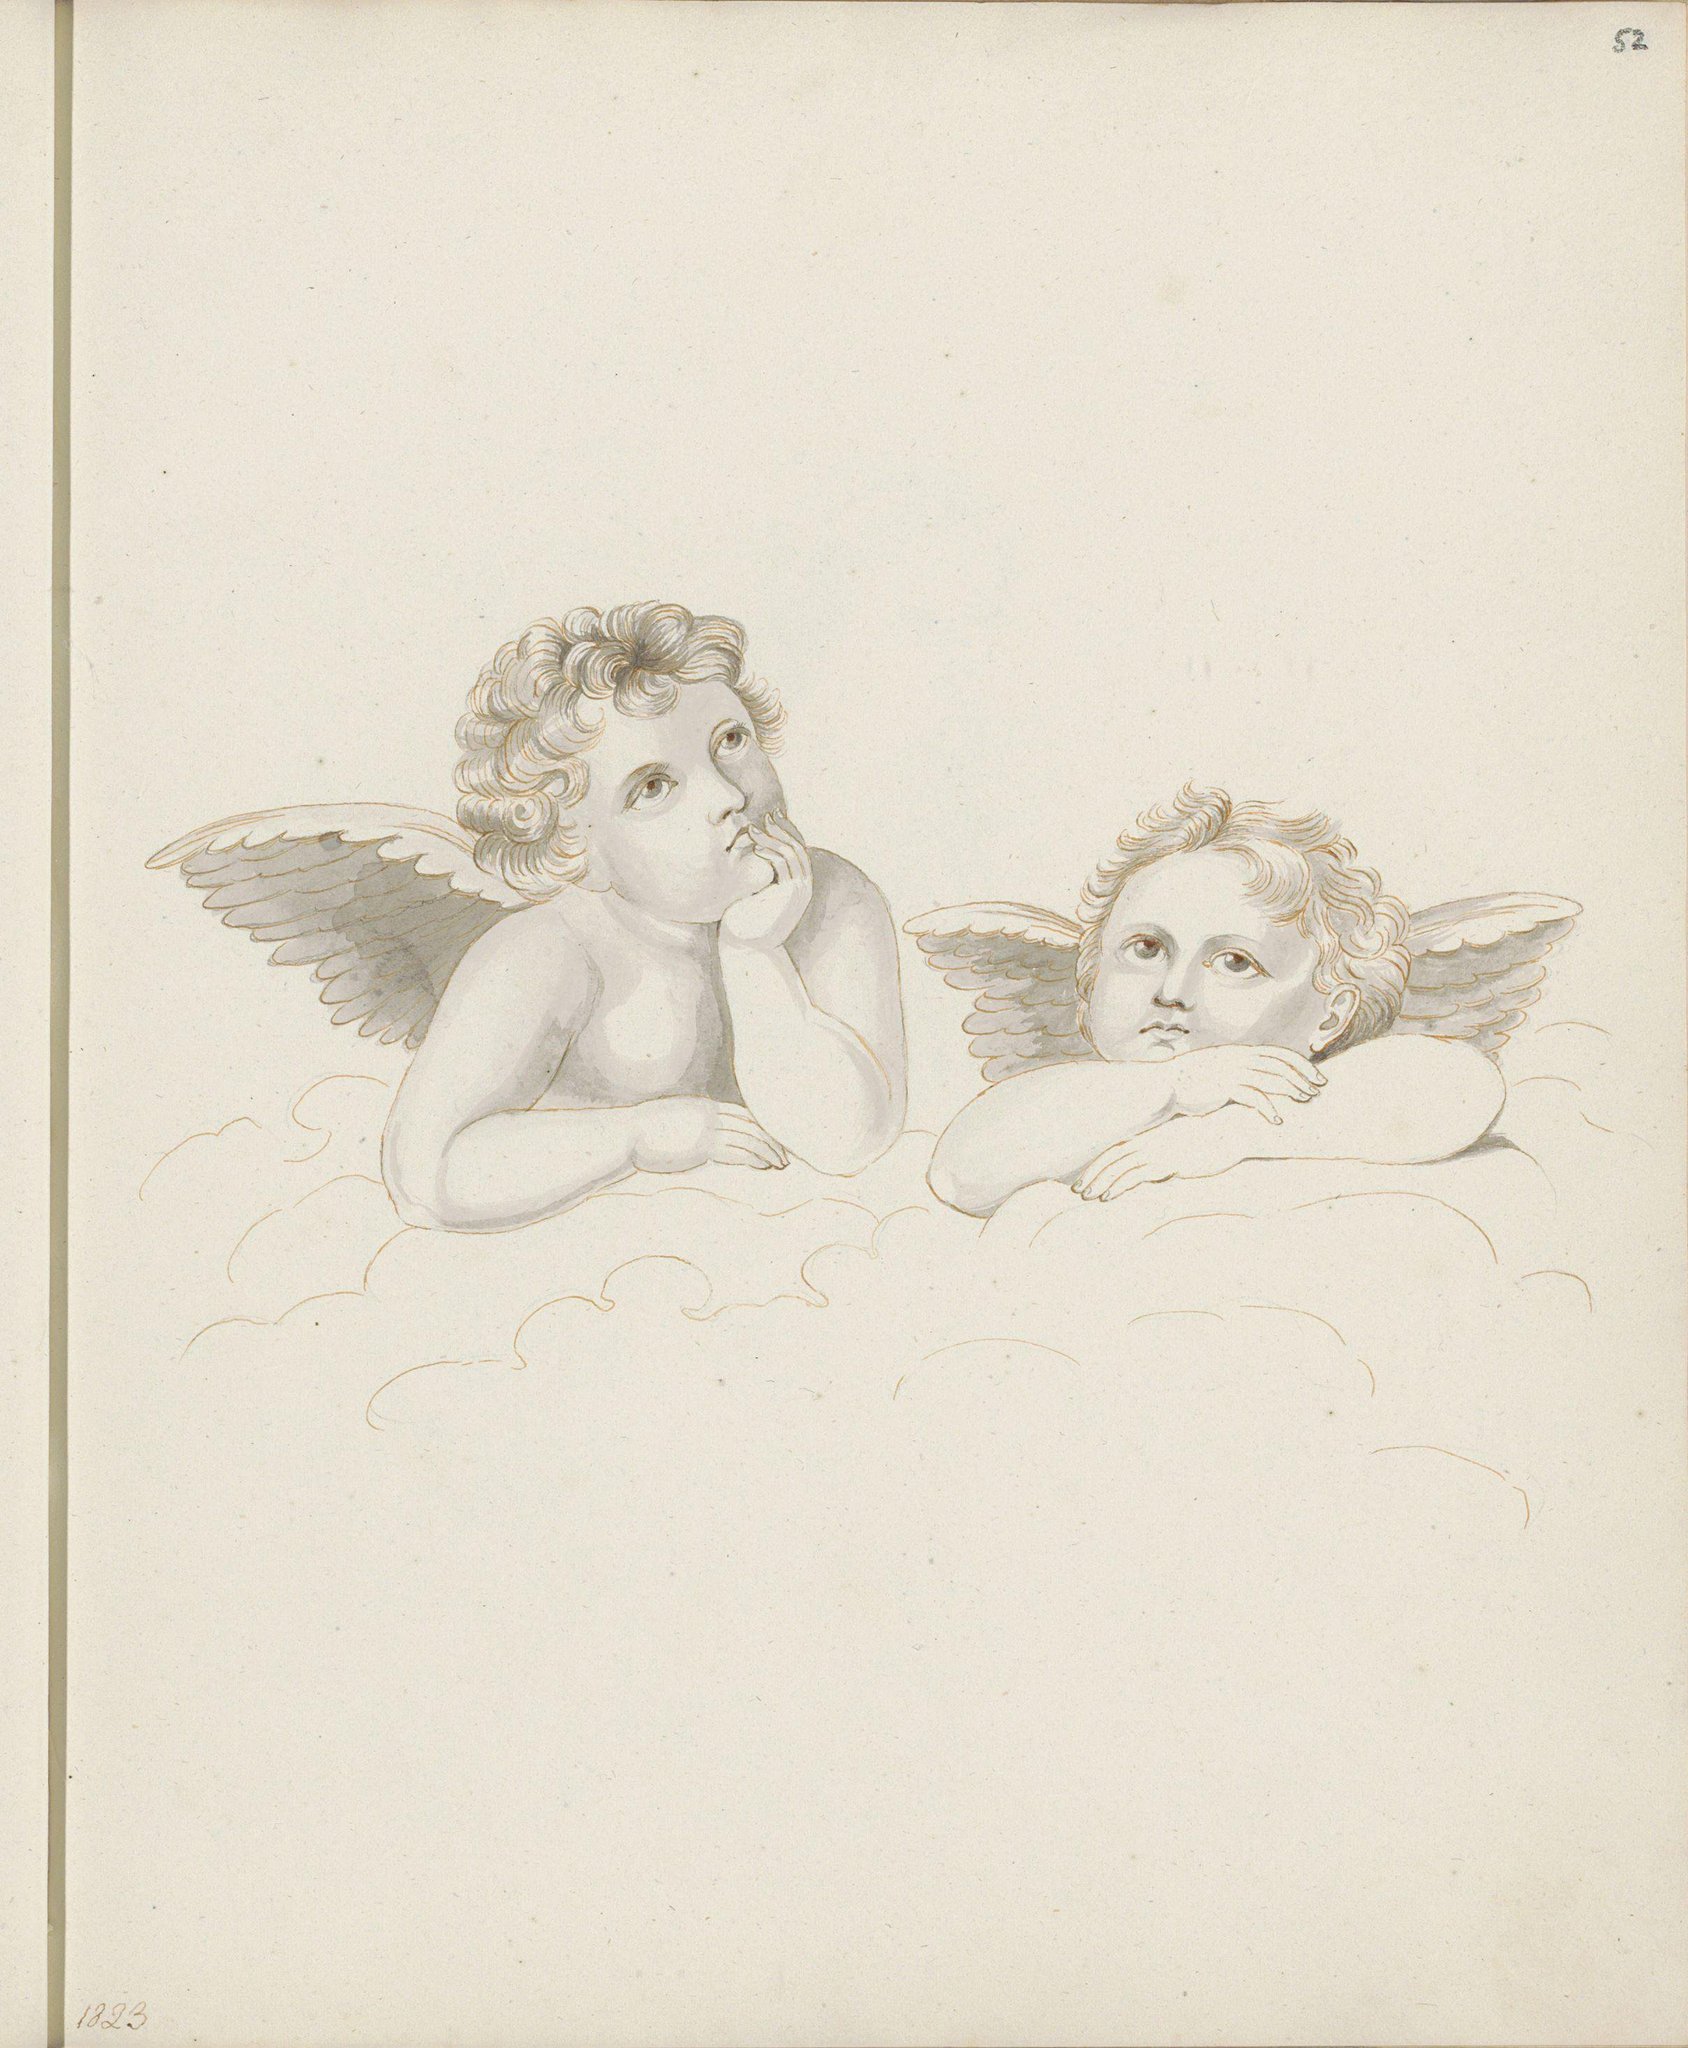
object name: sketchbook leaf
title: Twee cherubijnen naar een detail van Rafaëls 'Sixtijnse Madonna"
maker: jonkvrouw elisabeth kemper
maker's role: draughtsman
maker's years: 1799-1871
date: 1823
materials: ink, paper, pencil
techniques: brush, pen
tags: cherubim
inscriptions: date: ‘1823’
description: Blad 52 recto uit een schetsboek met 94 bladen.